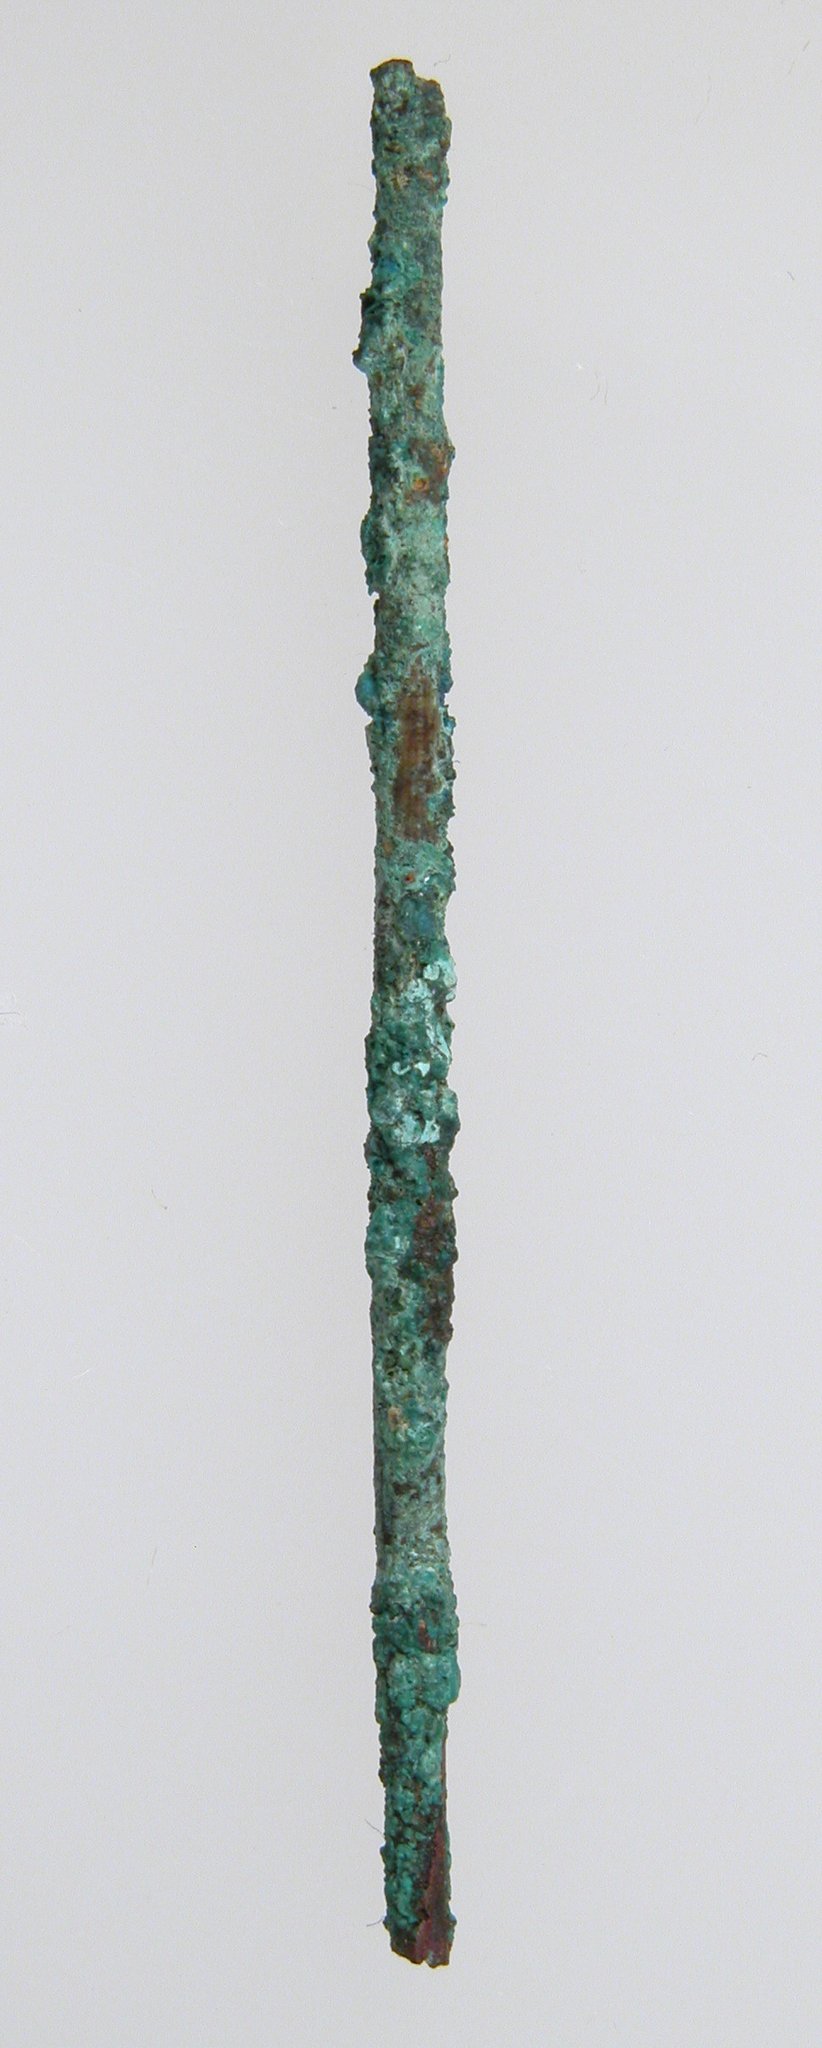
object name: hairpin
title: Hairpin Point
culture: roman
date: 200-500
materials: copper alloy